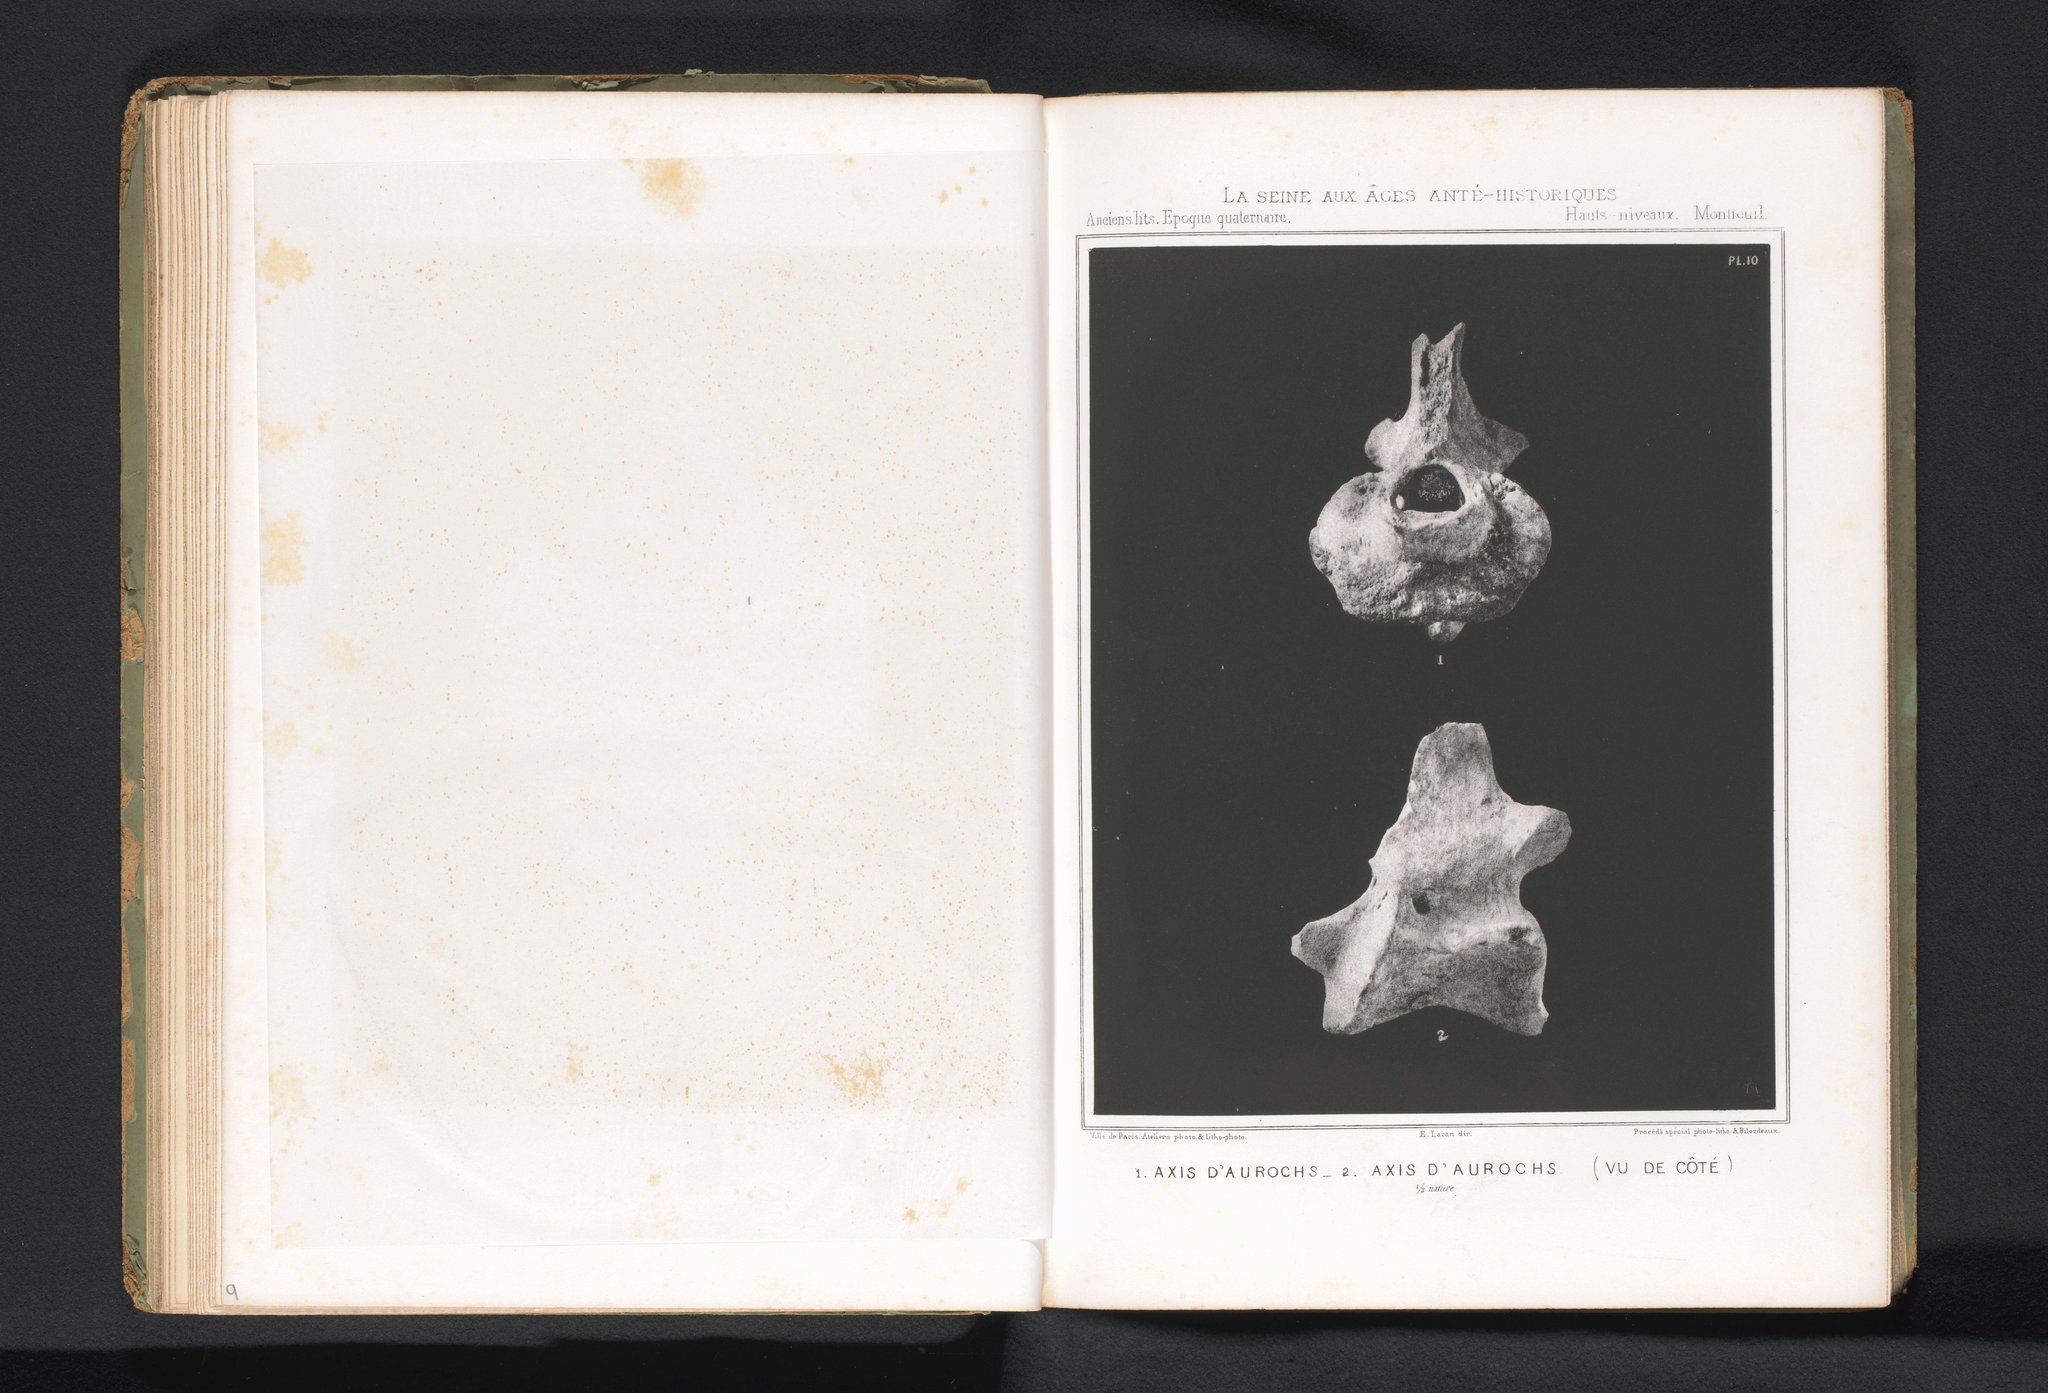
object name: photomechanical print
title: Twee aanzichten van de draaier uit de wervelkolom van een oeros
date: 1864-1869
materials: paper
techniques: photolithography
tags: animals (+ skeleton of an animal), palaeontology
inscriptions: number: ‘Pl. 10’, monogram: ‘AB’, inscription: ‘1. AXIS D'AUROCHS _ 2. AXIS D'AUROCHS (VU CÔTÉ)’, inscription: ‘Procedé spécial photo-litho. A. Bilordeaux’, inscription: ‘1/2 nature’